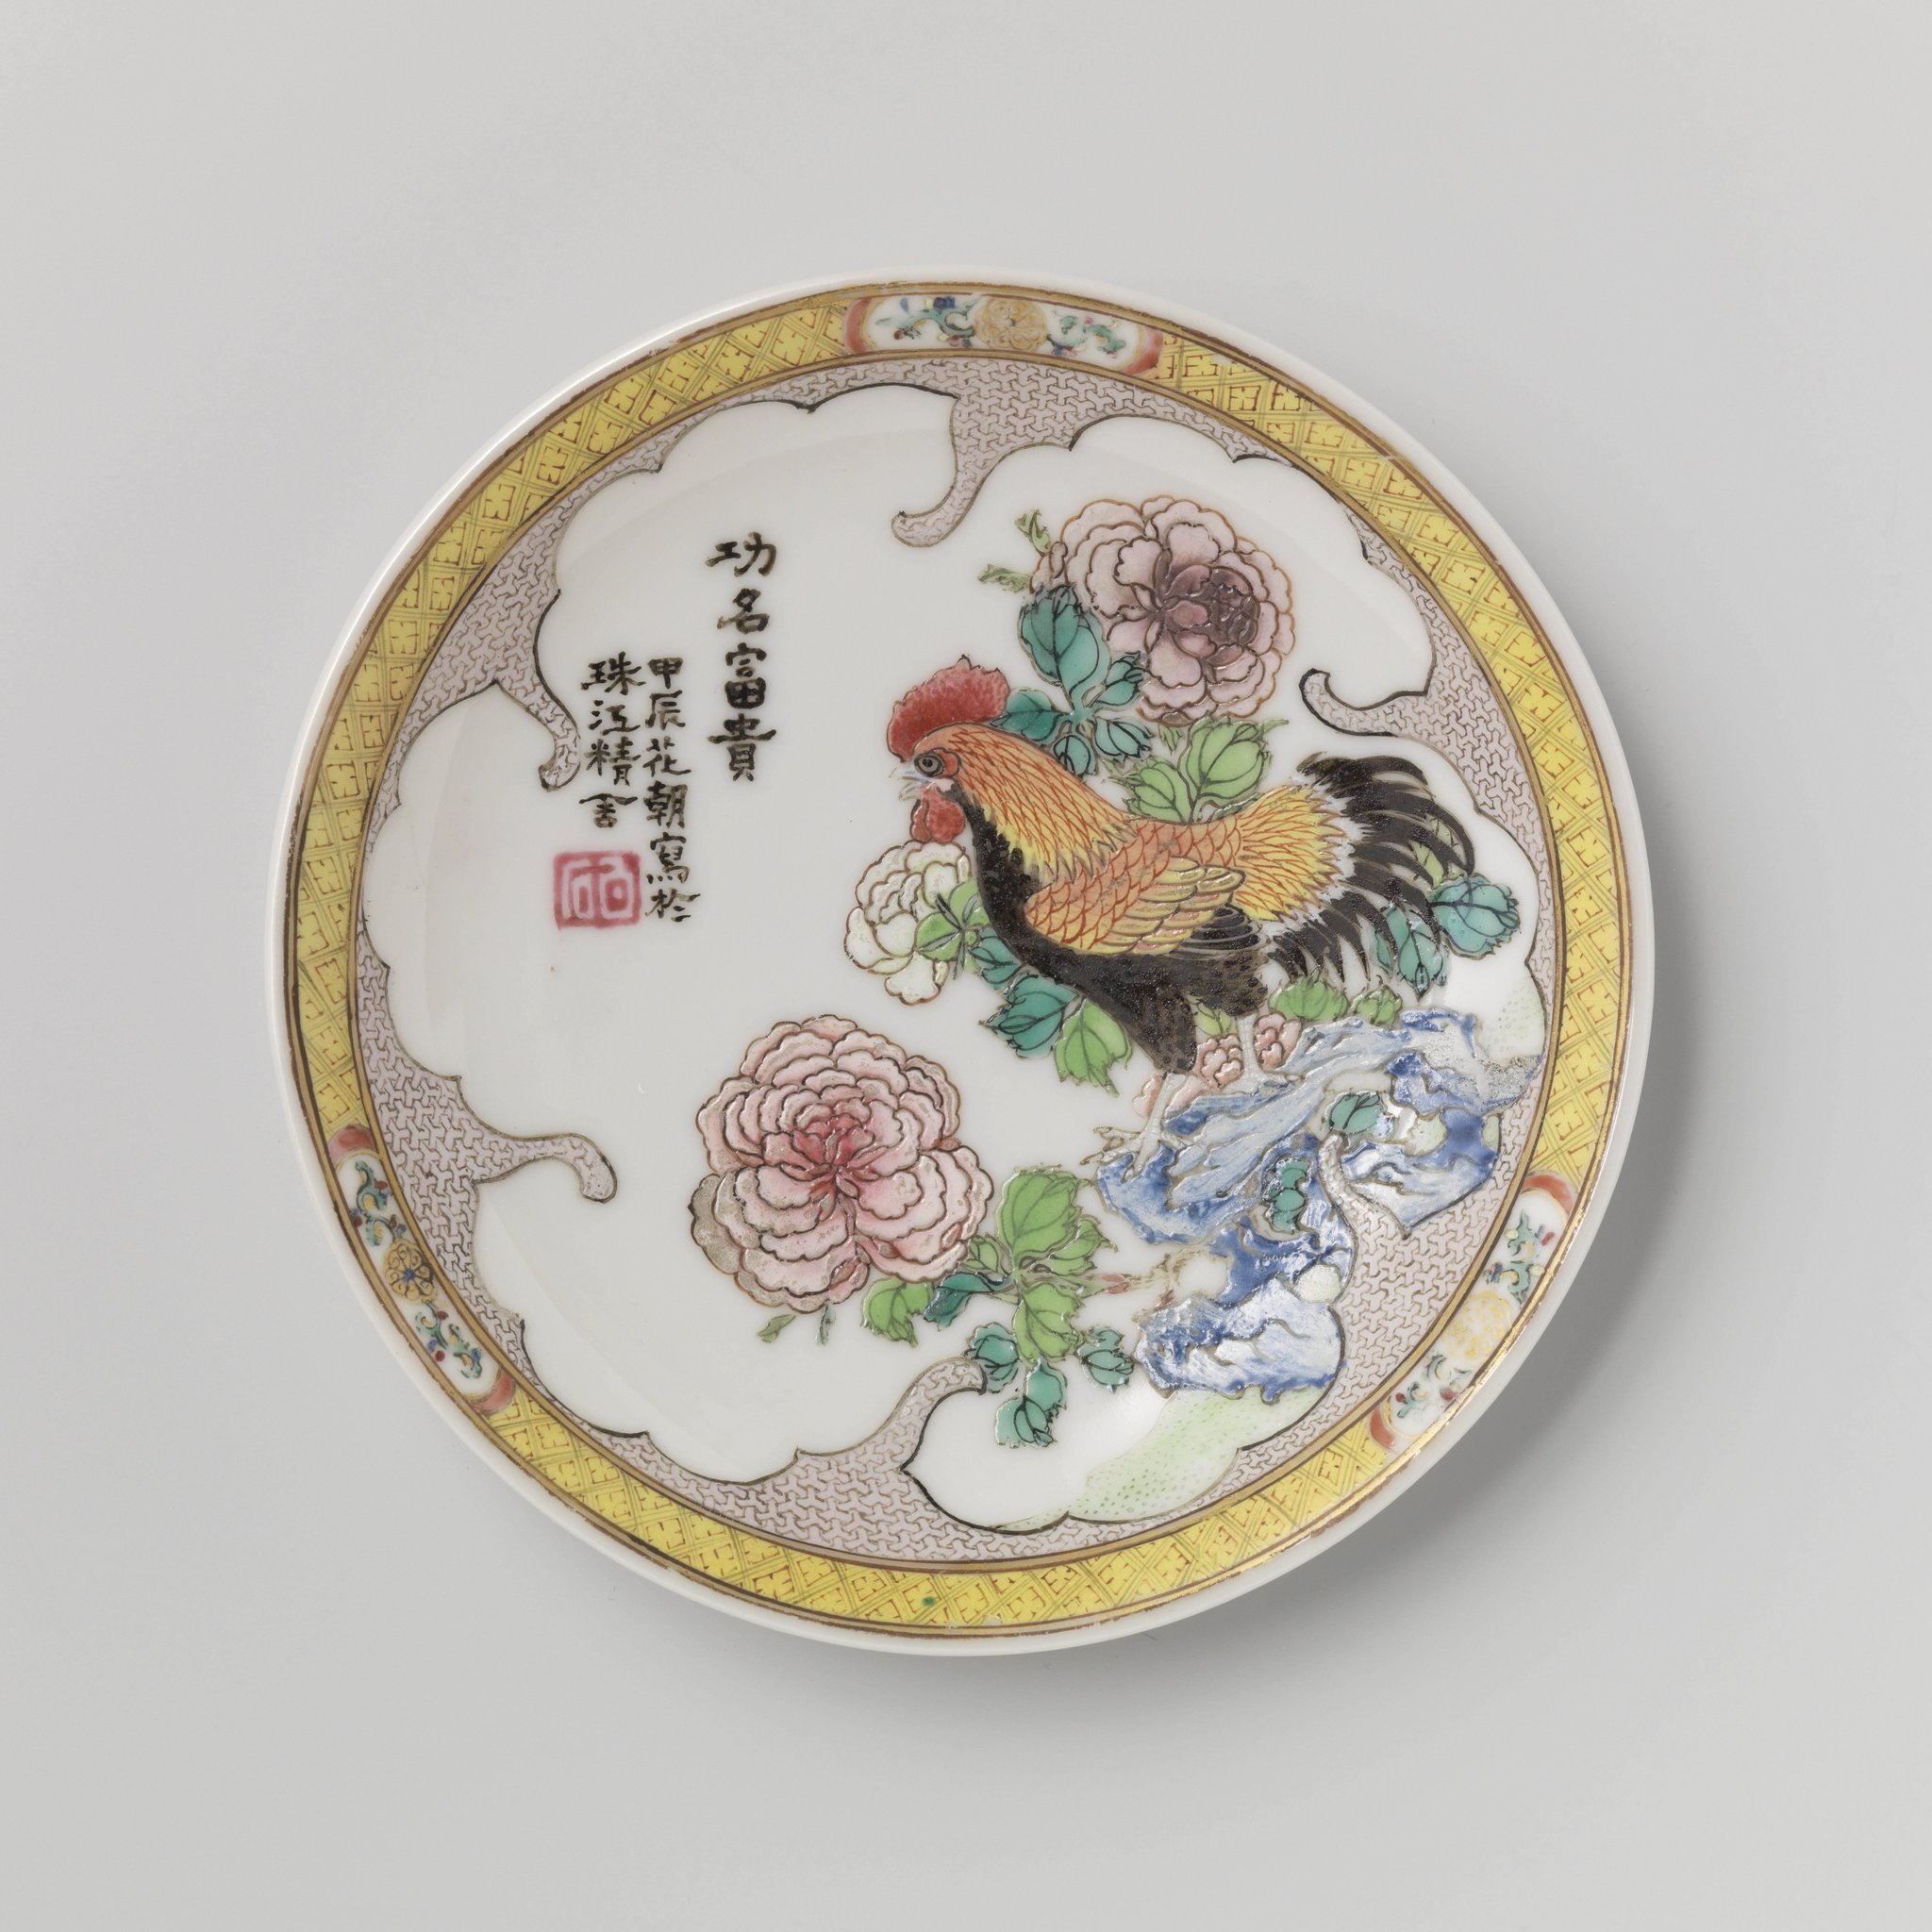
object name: platter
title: Saucer with a cock on a rock with flowering plants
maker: Anonymous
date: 1724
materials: glaze, gold, paint, porcelain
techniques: firing, gilding, turning, vitrification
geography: china